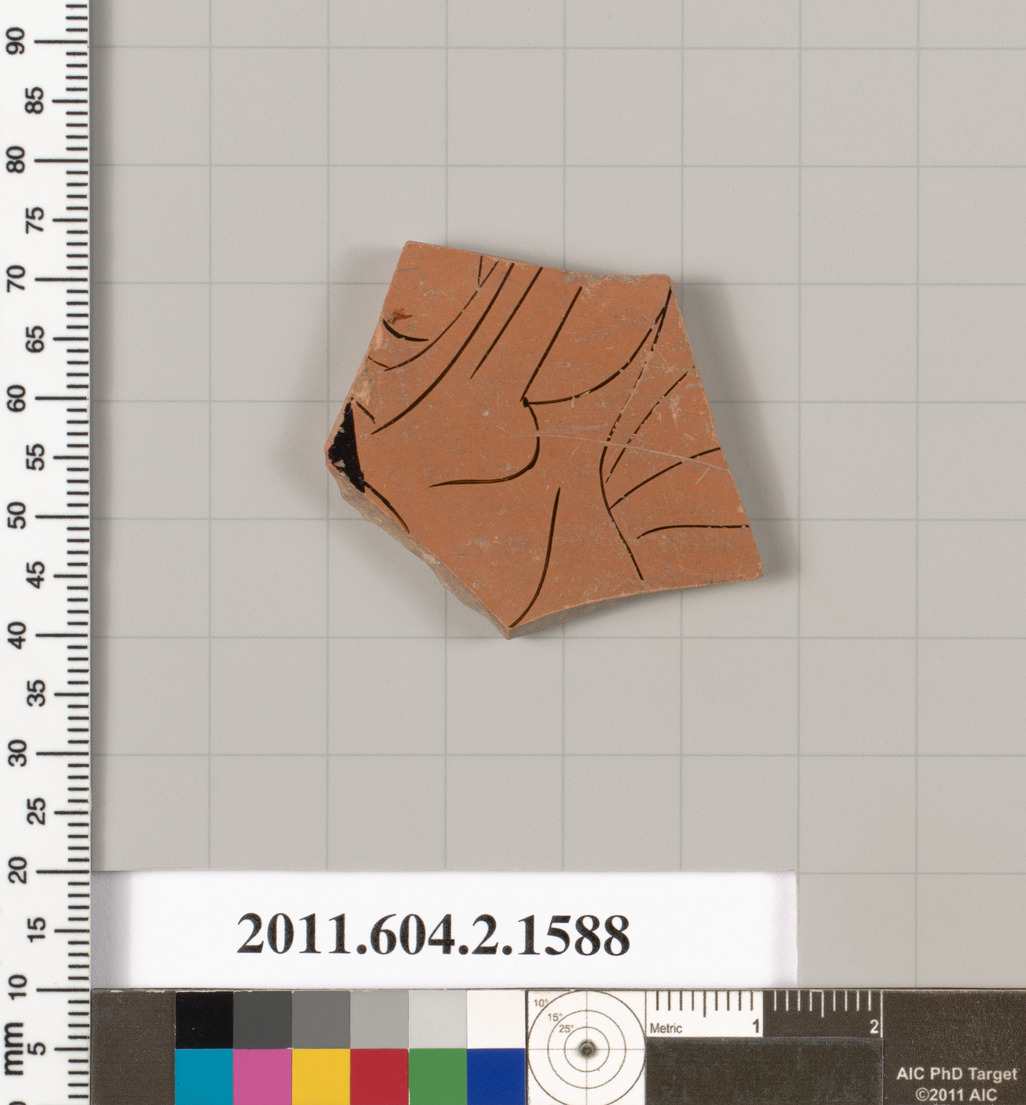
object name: skyphos fragment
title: Terracotta fragment of a skyphos (deep drinking cup)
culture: greek, attic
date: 475-451 BCE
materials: terracotta